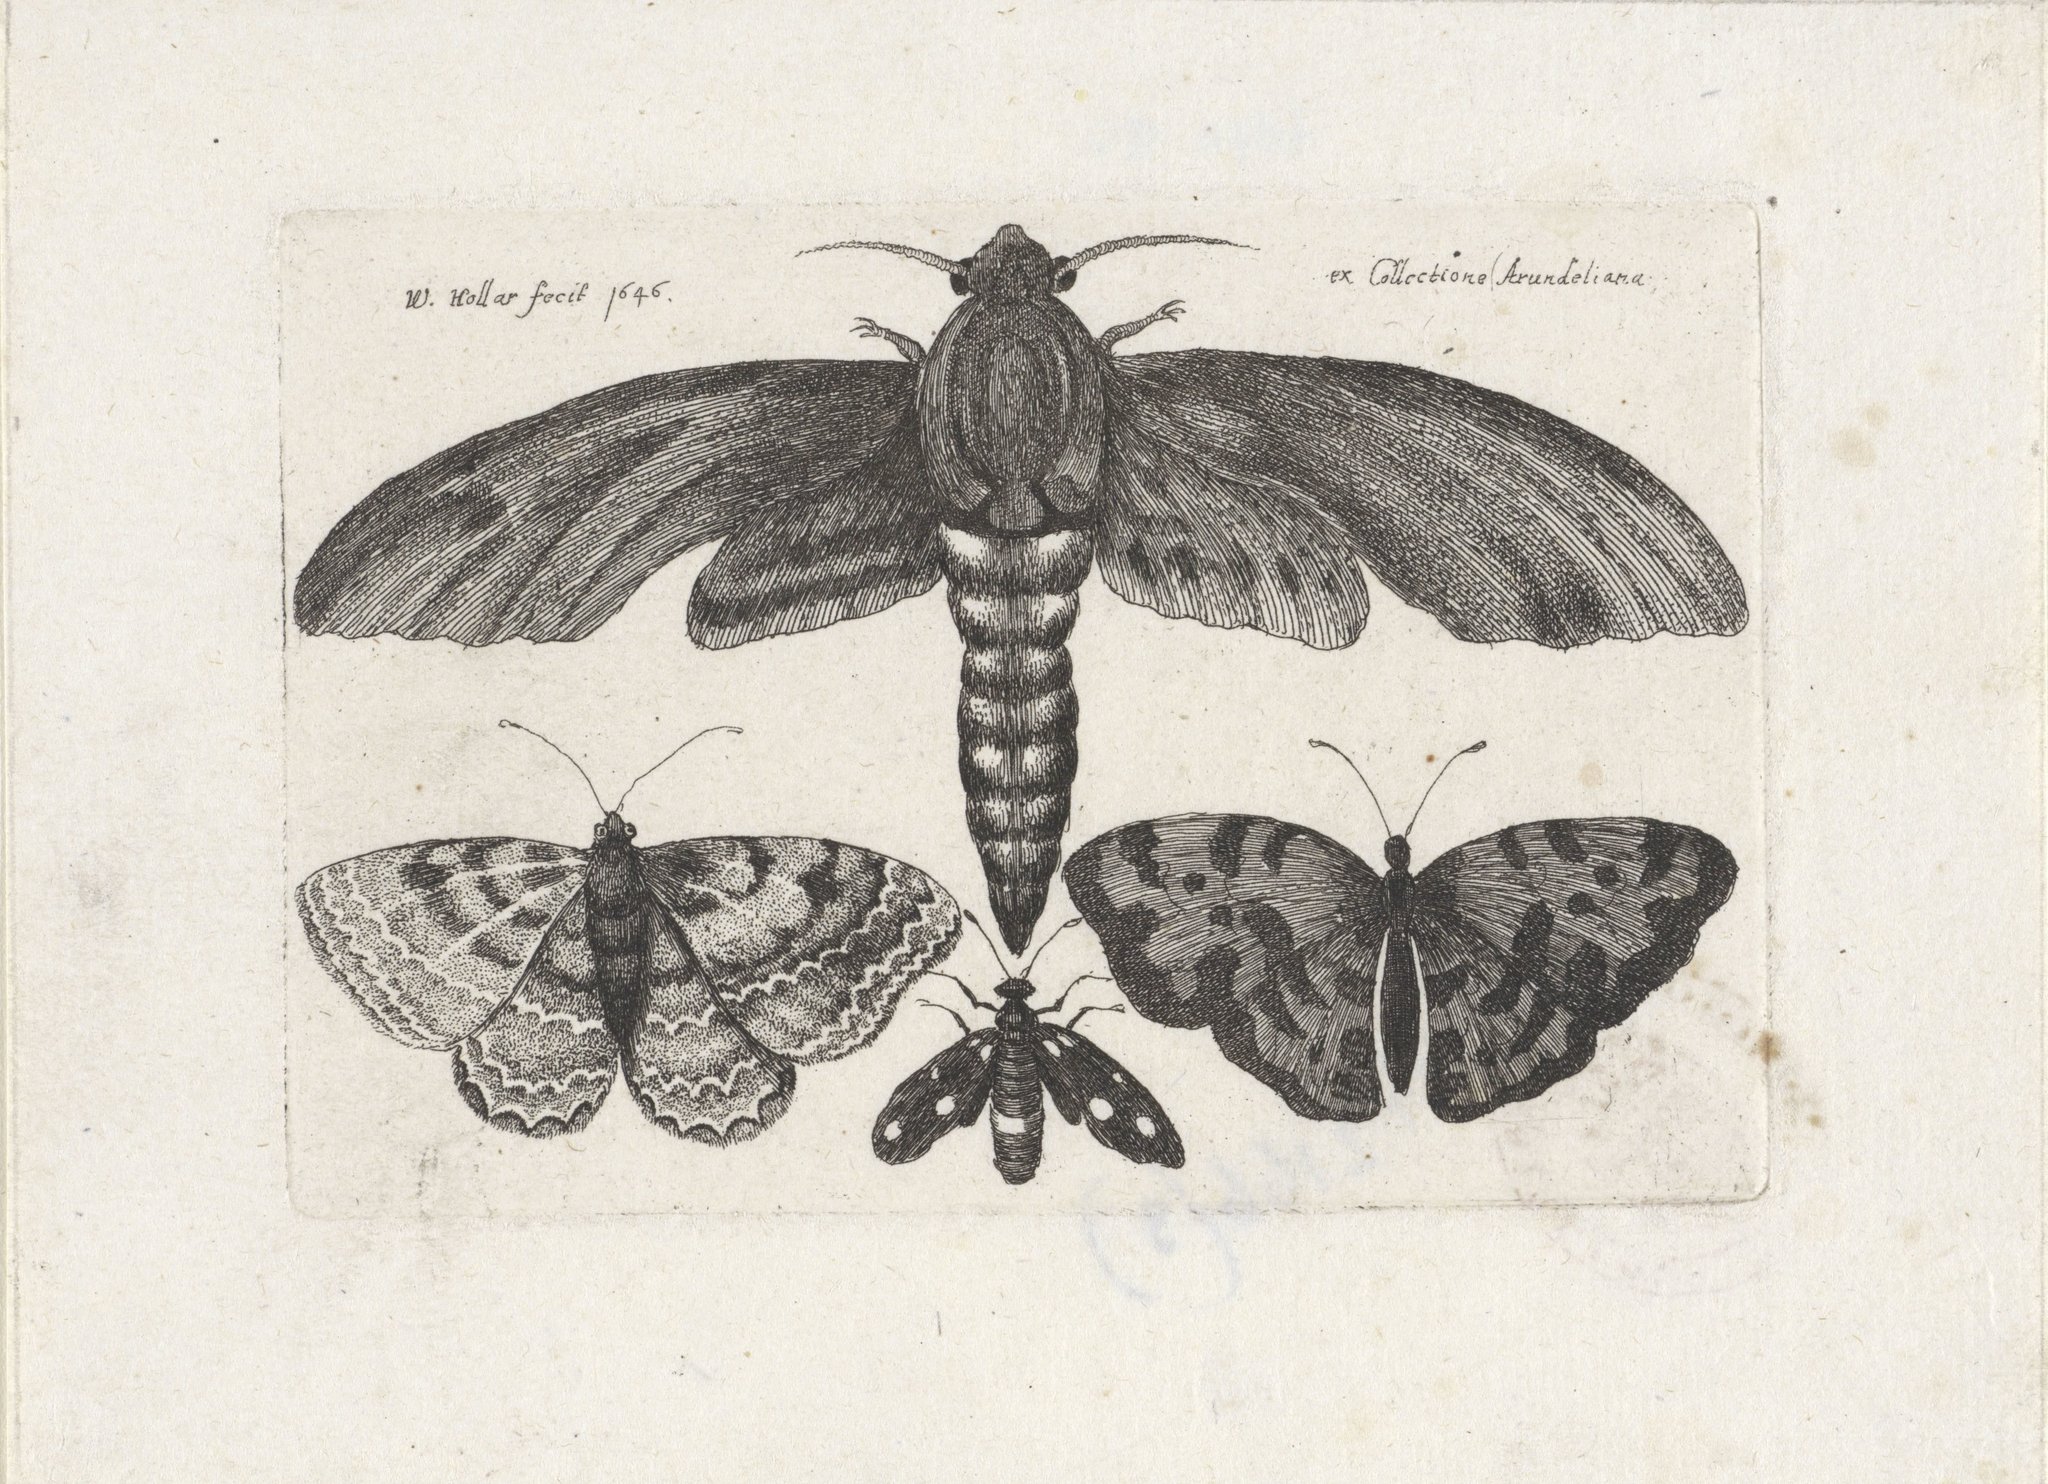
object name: print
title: Vlinders en een mot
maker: wenceslaus hollar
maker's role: draughtsman, print maker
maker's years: 1607-1677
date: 1646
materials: paper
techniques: etching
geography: antwerp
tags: insects: moth, insects: butterfly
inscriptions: collector's mark: Lugt 240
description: Prent maakt deel uit van de twaalfdelige serie (incl. titelprent) met verschillende insecten: "Muscarum Scarabeorum".